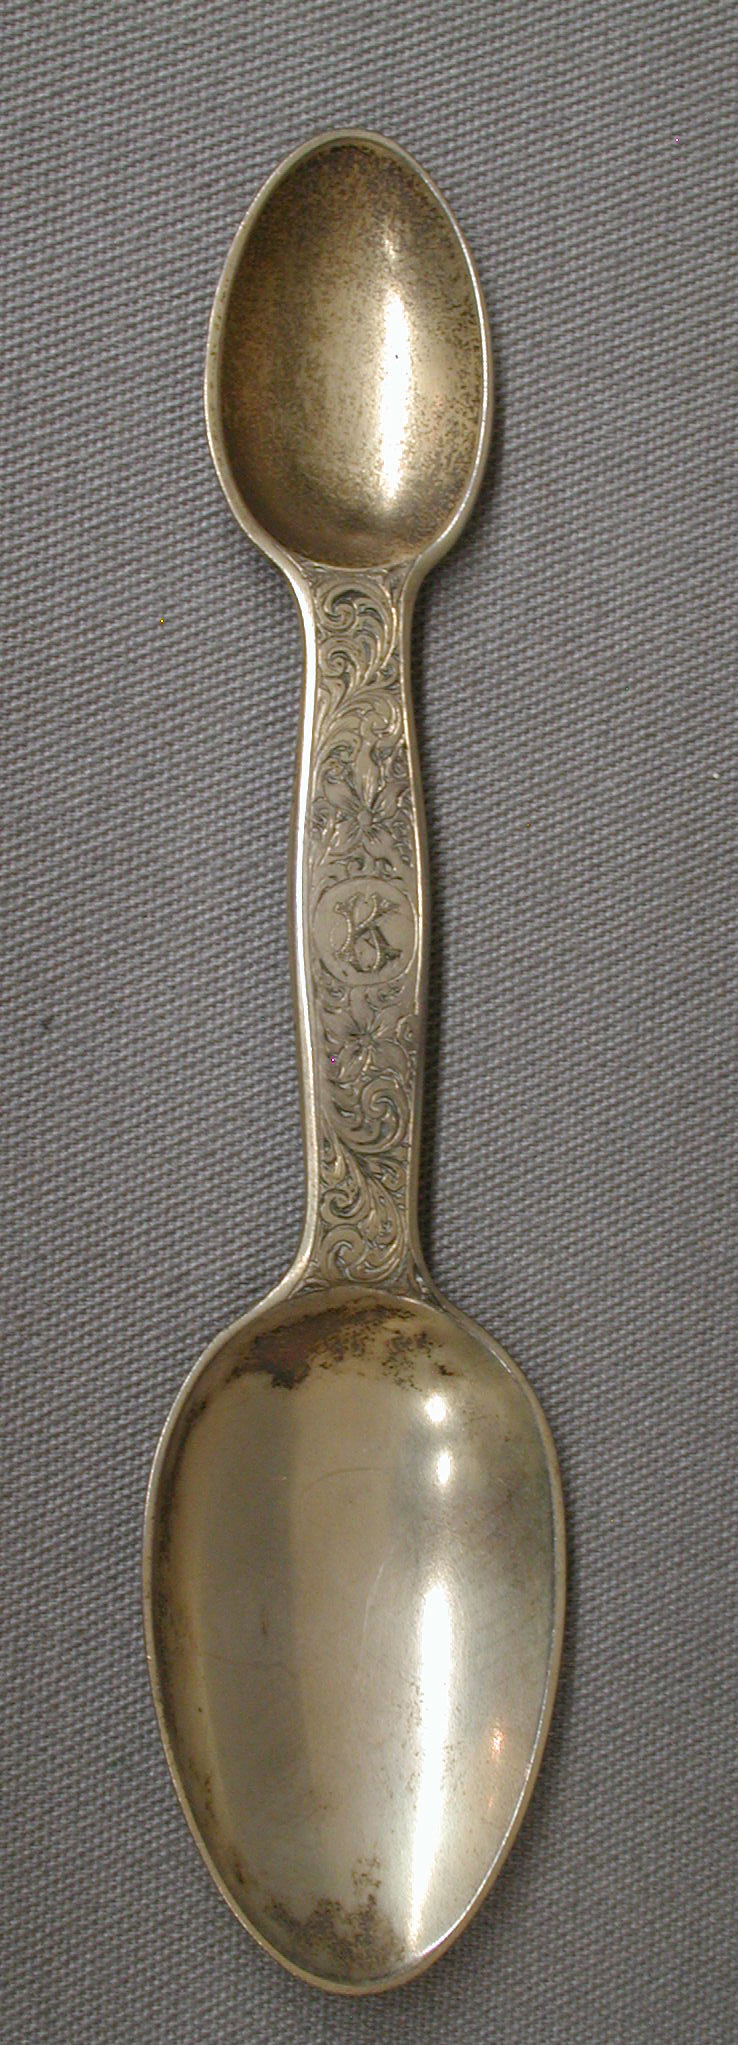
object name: spoon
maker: h. h., london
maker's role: maker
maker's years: 1874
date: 1874-1875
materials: silver